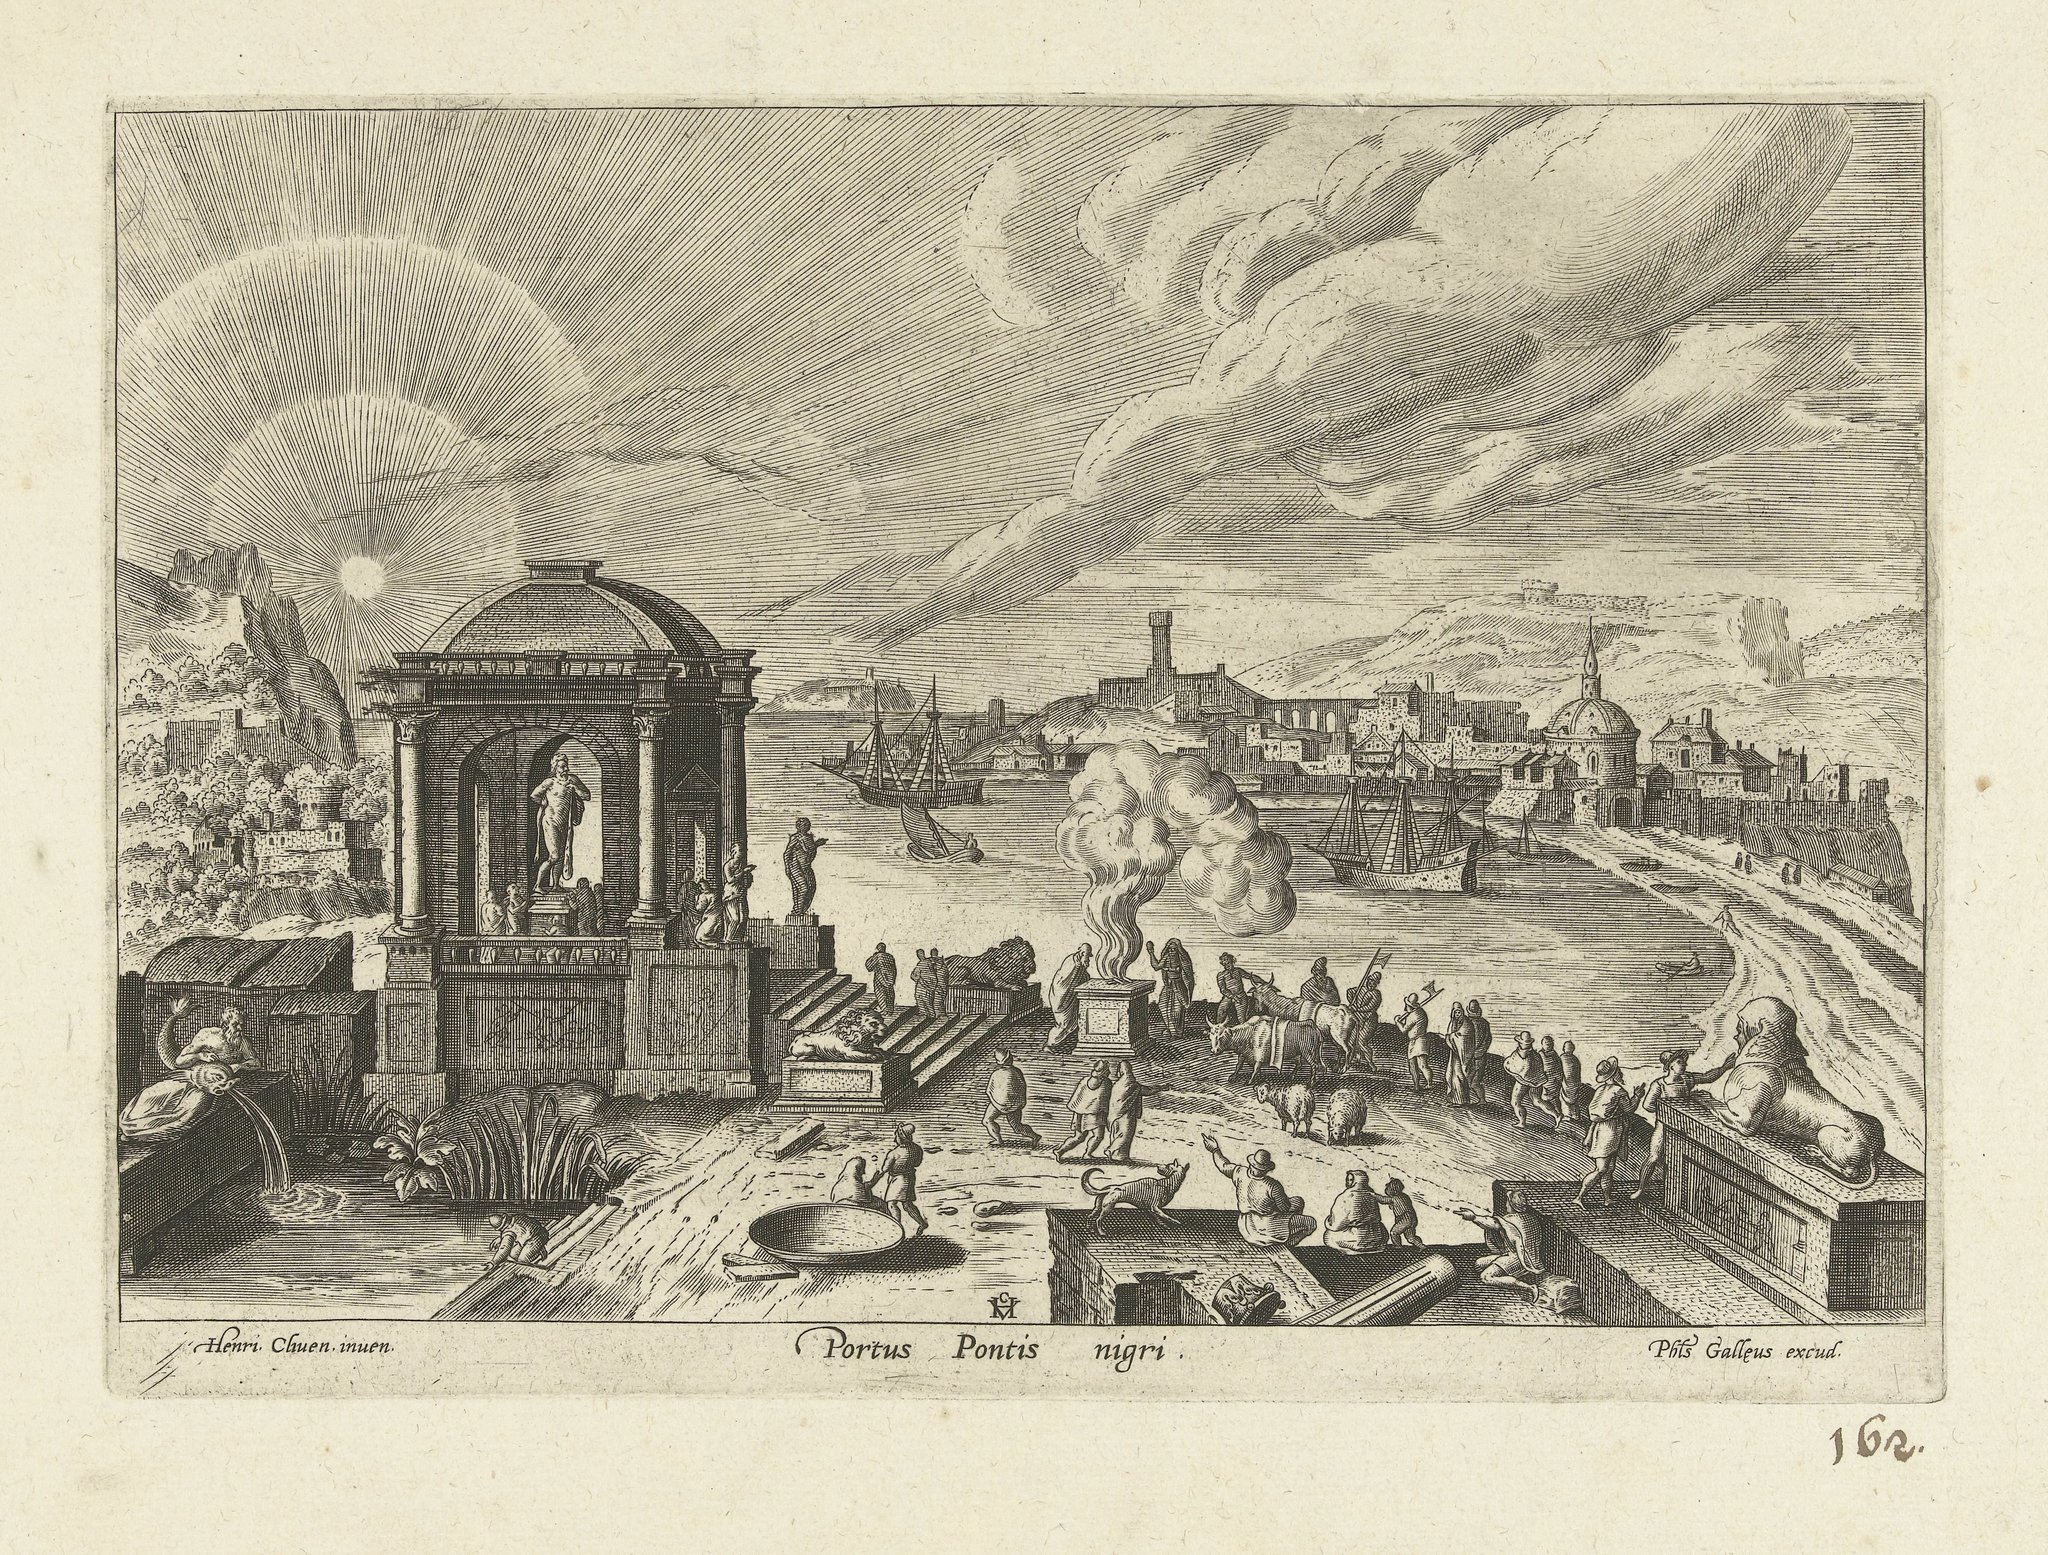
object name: print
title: Ruinarum varii prospectus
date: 1585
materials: paper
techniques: engraving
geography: antwerp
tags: city-view in general; 'veduta'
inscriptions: number: ‘162’, collector's mark: Lugt 2228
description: Gezicht op de haven van het Griekse eiland Euboea. Op de voorgrond worden twee stieren geofferd voor een tempel. De prent is deel van een serie die verschillende plaatsen in het Middellandse Zeegebied afbeeldt.